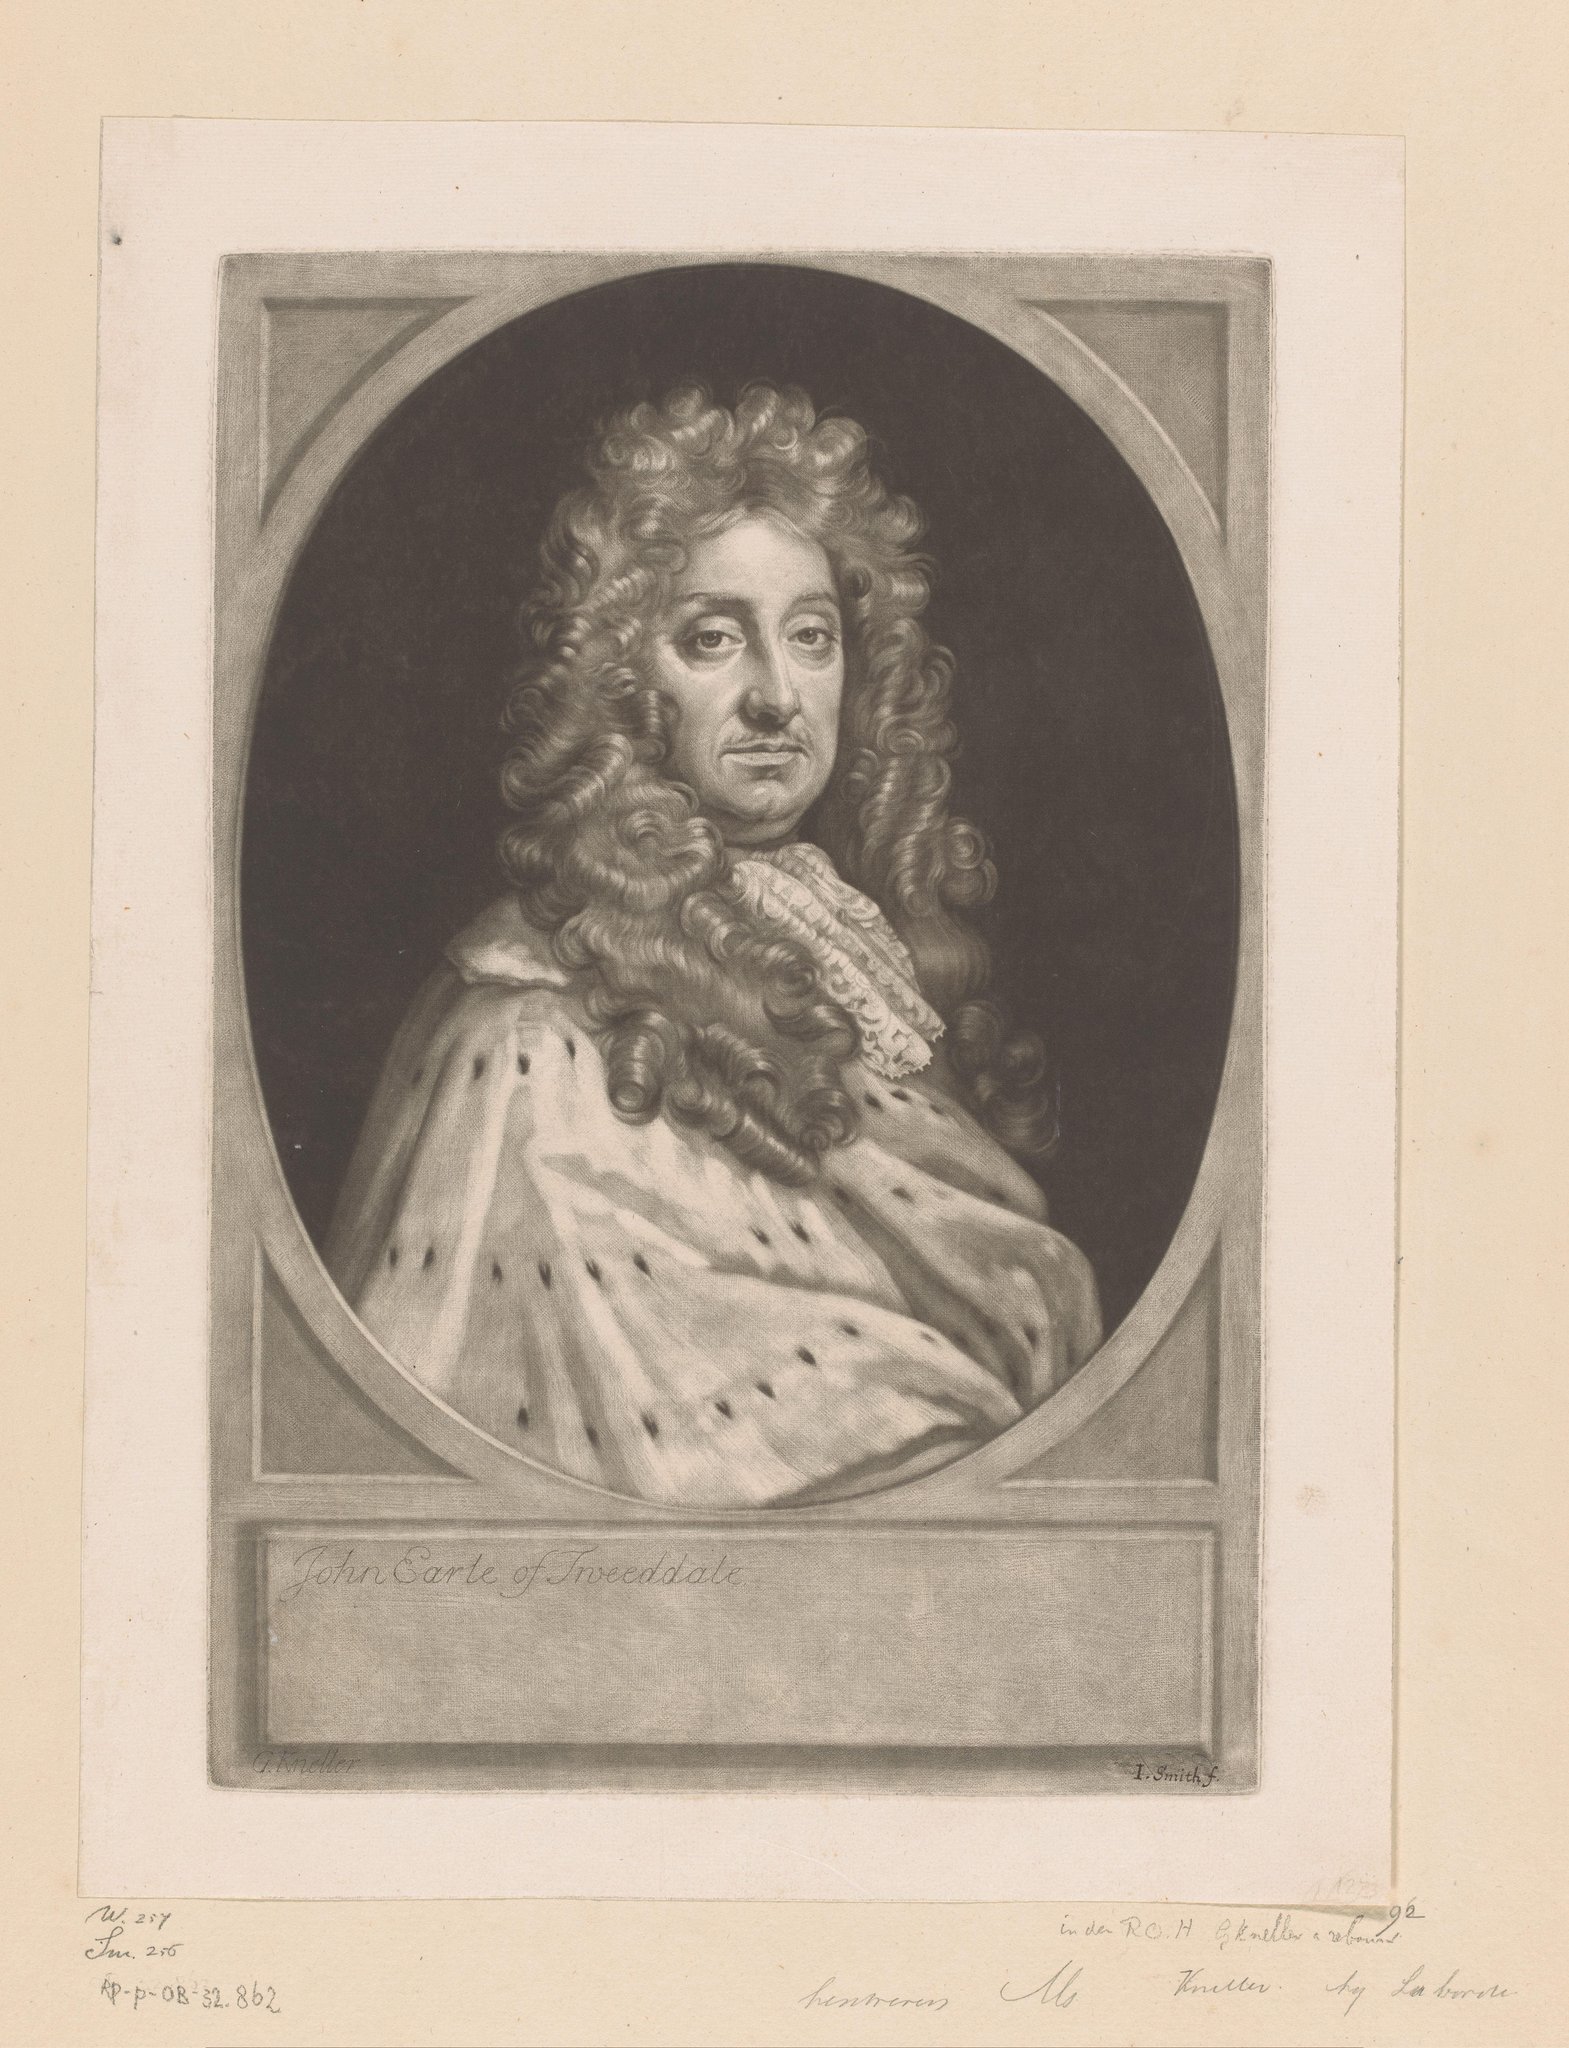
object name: print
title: Portret van John Hay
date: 1662-1742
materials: paper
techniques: mezzotint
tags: jury, historical persons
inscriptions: collector's mark: Lugt 240